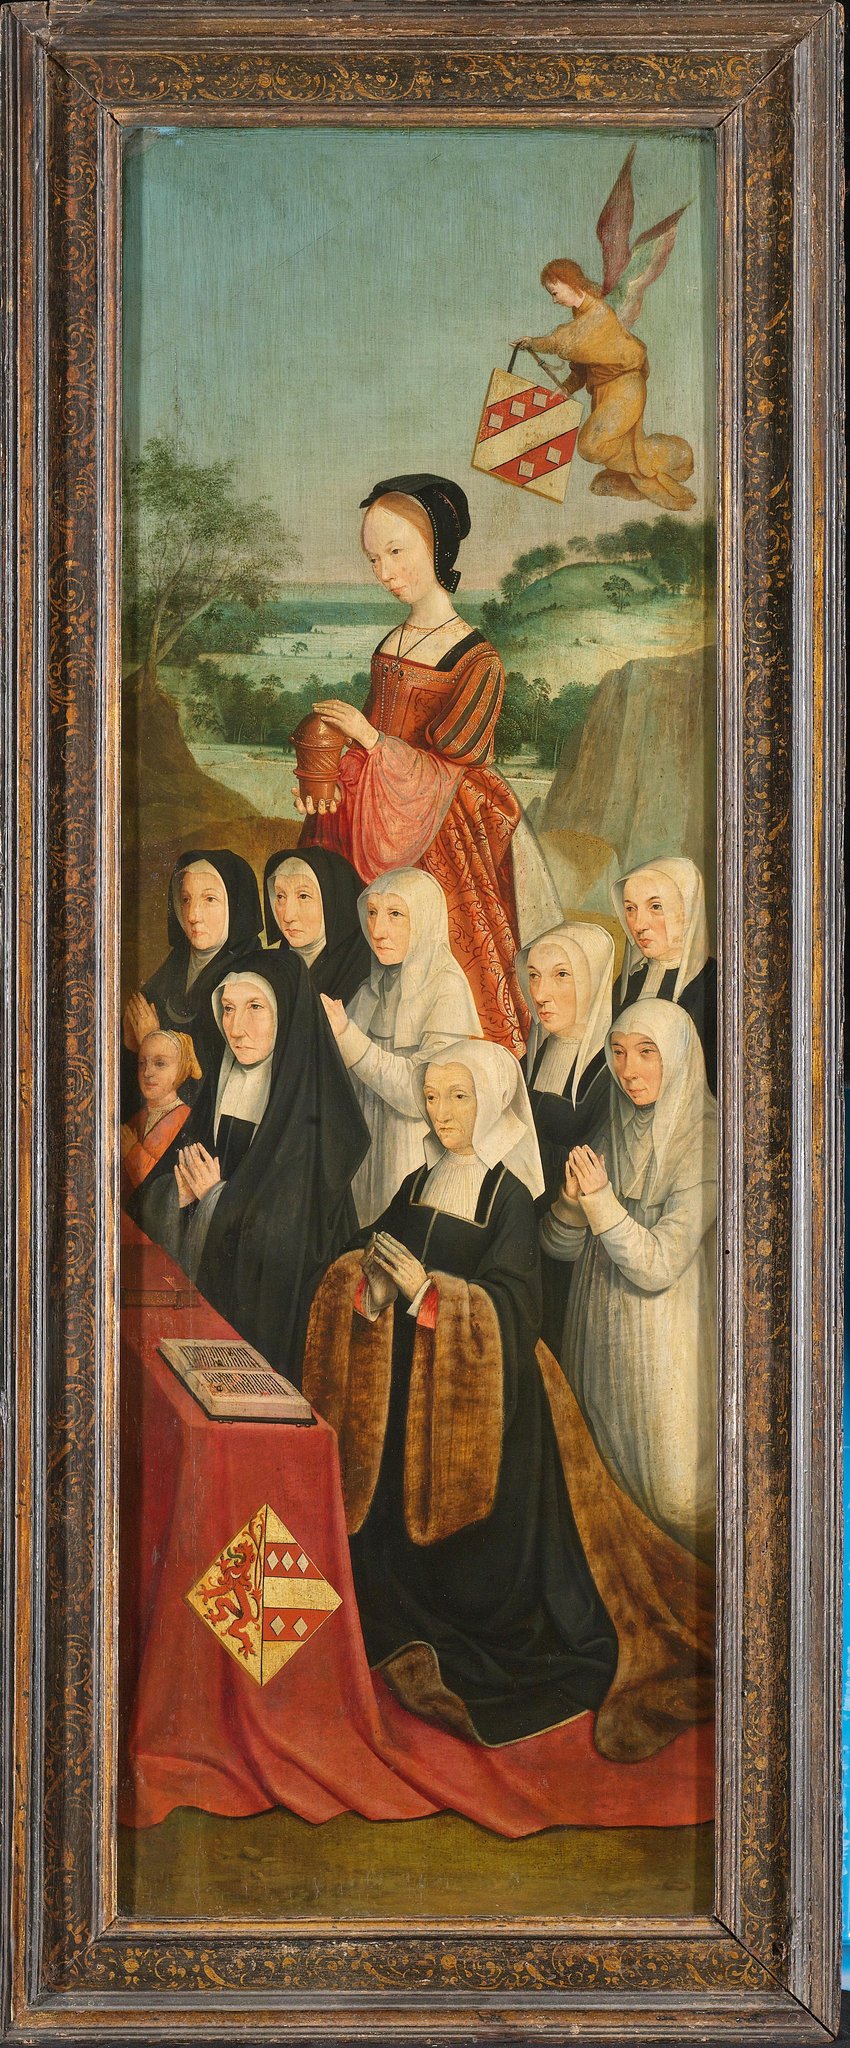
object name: painting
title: Memorial Panel with Nine Female Portraits, probably Kathrijn Willemsdr van der Graft and Family, with Saint Mary Magdalene and the Van Soutelande Family and Van der Graft-Van Soutelande Crests, inner right wing of an altarpiece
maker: master of alkmaar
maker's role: painter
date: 1515-1520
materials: oil, paint, panel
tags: historical persons - bb - woman, historical persons not known by name - bb - woman, female saints (with name), armorial bearing, heraldry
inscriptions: coat of arms, lower left, on the end of the prie-dieu: divided vertically, 1, a red lion with two tails, blue tongue and claws, a crescent moon on its chest, on a gold field; 2, two horizontal red bars charged with five silver lozenges, three above two, on a gold field, coat of arms, on the reverse: same coat as 2 on the front, lower left, coat of arms, upper right, held by an angel: two horizontal red bars charged with five silver lozenges, three above two, on a gold field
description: Zijluik van een memoriestuk met acht portretten van mannen en negen van vrouwen, respectievelijk vergezeld van de heiligen Jacobus Major en Maria Magdalena. Op het linkerpaneel (SK-A-1188-A) de knielende stichter Willem Jelysz van Soutelande (overl. 1515-16) in de wapenrusting van een ridder van de Broederschap van de Heilige Land. Voor zich een altaar met een opengeslagen boek, achter zich zeven mannen (zijn zoons?) en de heilige Jacobus Major. In de lucht een engel met het wapen van Jacob de Wael van Rozenburg (overl. 1524) een burger van Haarlem. Op het rechterpaneel de knielende stichteres Kathrijn van der Graft Willemsdochter (overl. 1490-91), eveneens knielend in aanbidding voor een altaar met opengeslagen boek. Achter haar acht vrouwen (haar dochters?) en de heilige Maria Magdalena. In de lucht een engel met het wapen van Margriet van Waveren. Op de buitenzijden van de panelen staan de wapens van Van Soutelande en het alliantiewapen Van der Graft-Van Soutelande.